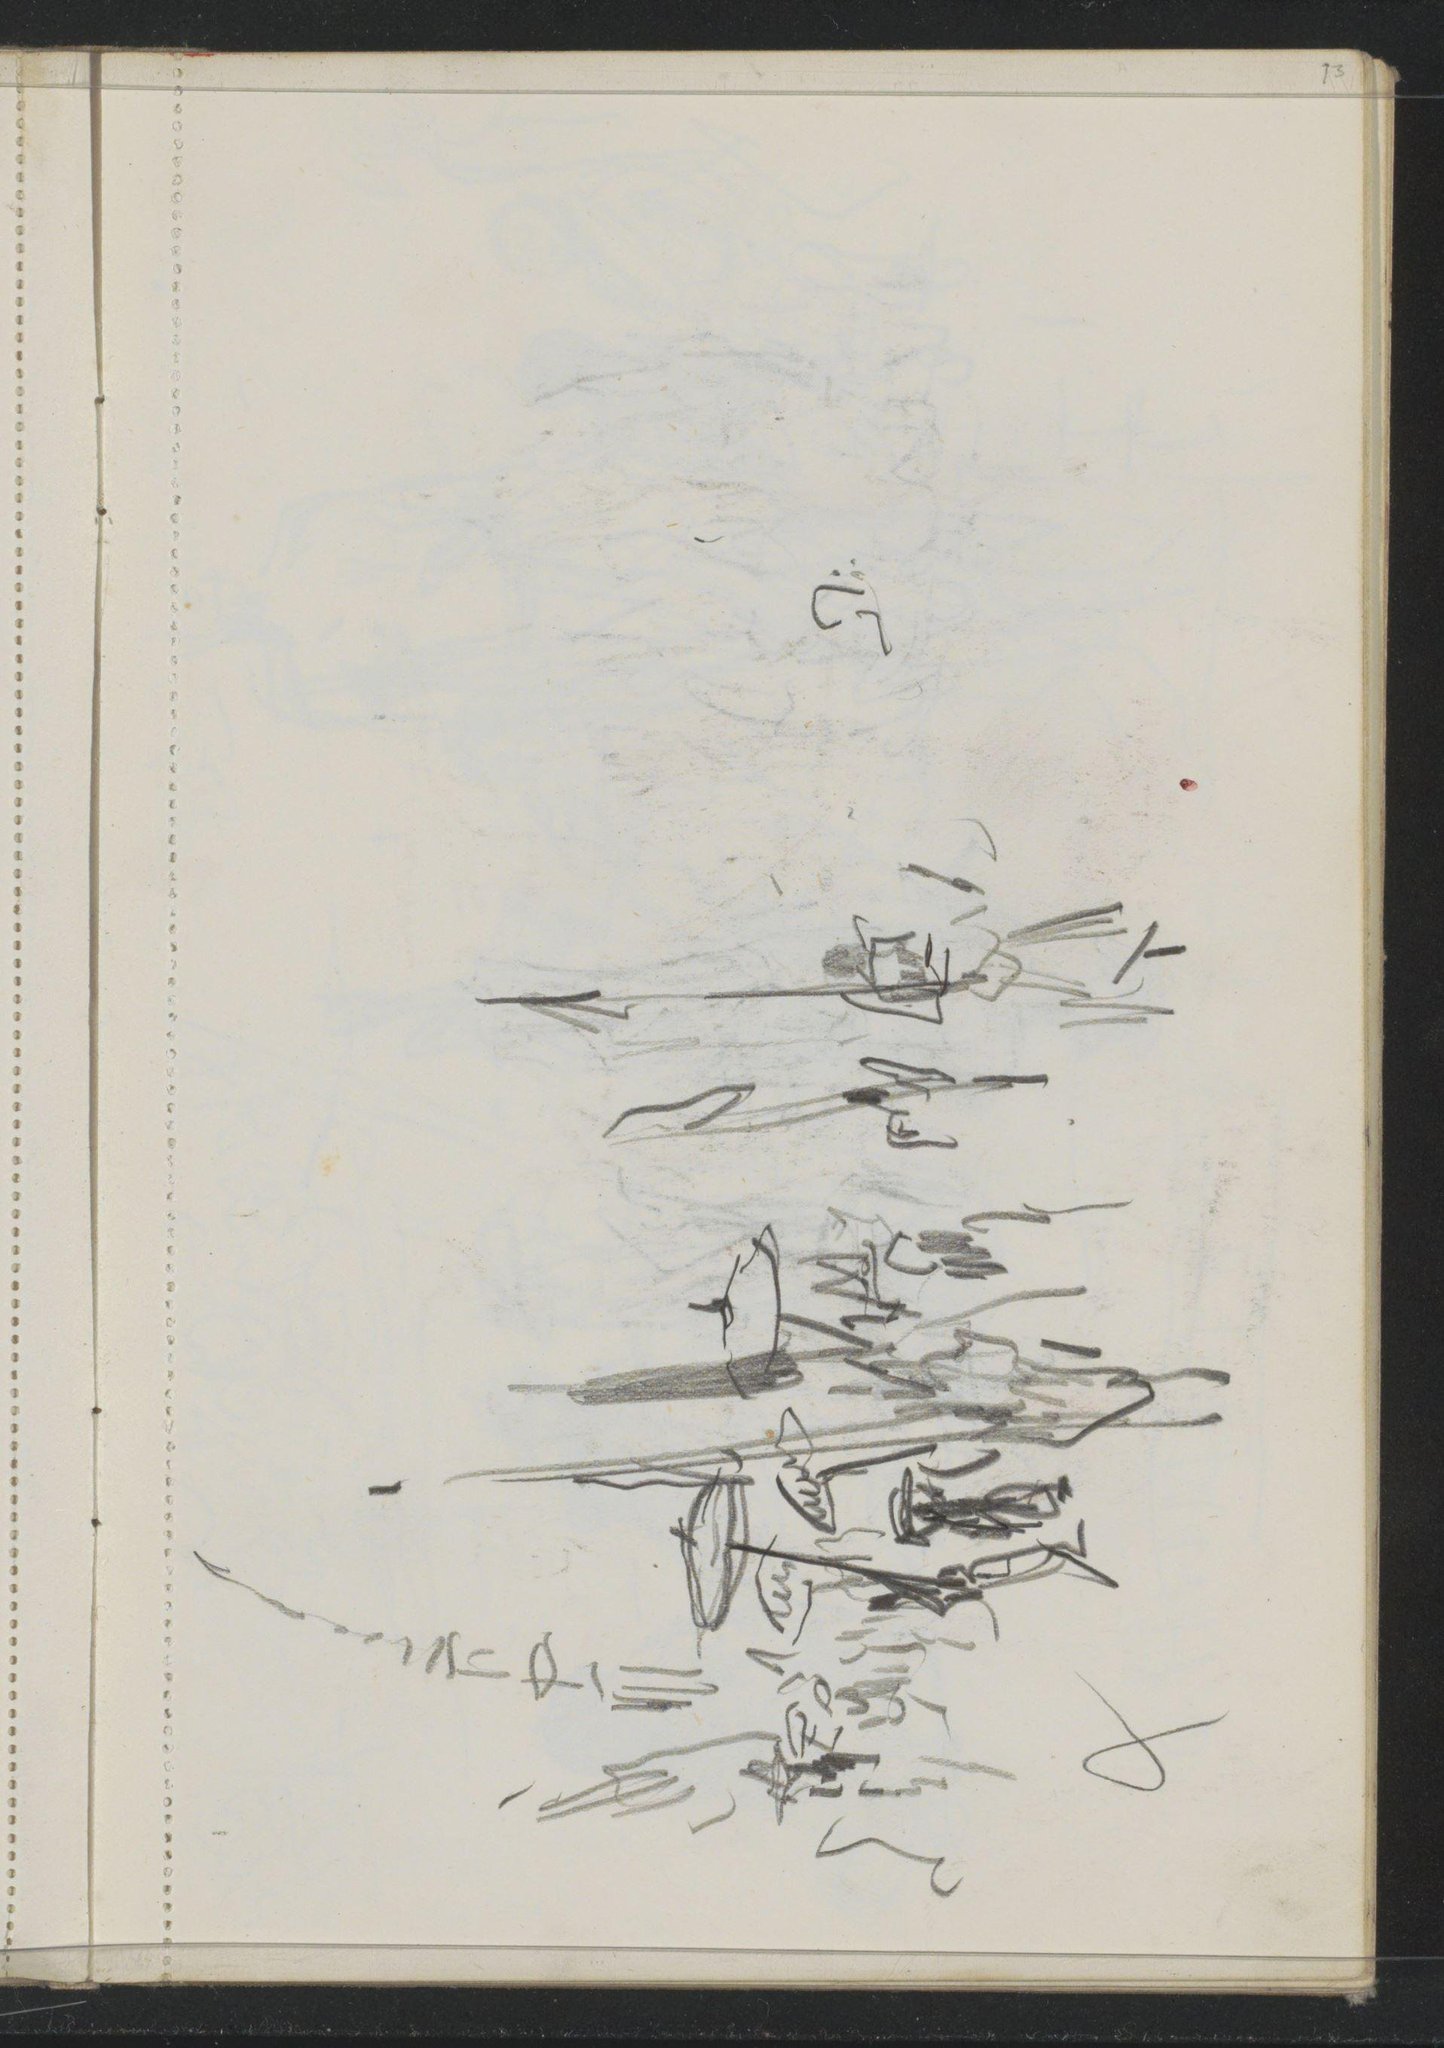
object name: sketchbook leaf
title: Optocht van figuren met parasols en vlaggen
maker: marius bauer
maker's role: draughtsman, print maker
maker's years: 1867-1932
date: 1925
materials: paper, pencil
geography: indonesia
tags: standard-bearer, flag-bearer, walking, parasol, sunshade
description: Pagina 73 uit een schetsboek met 74 bladen.